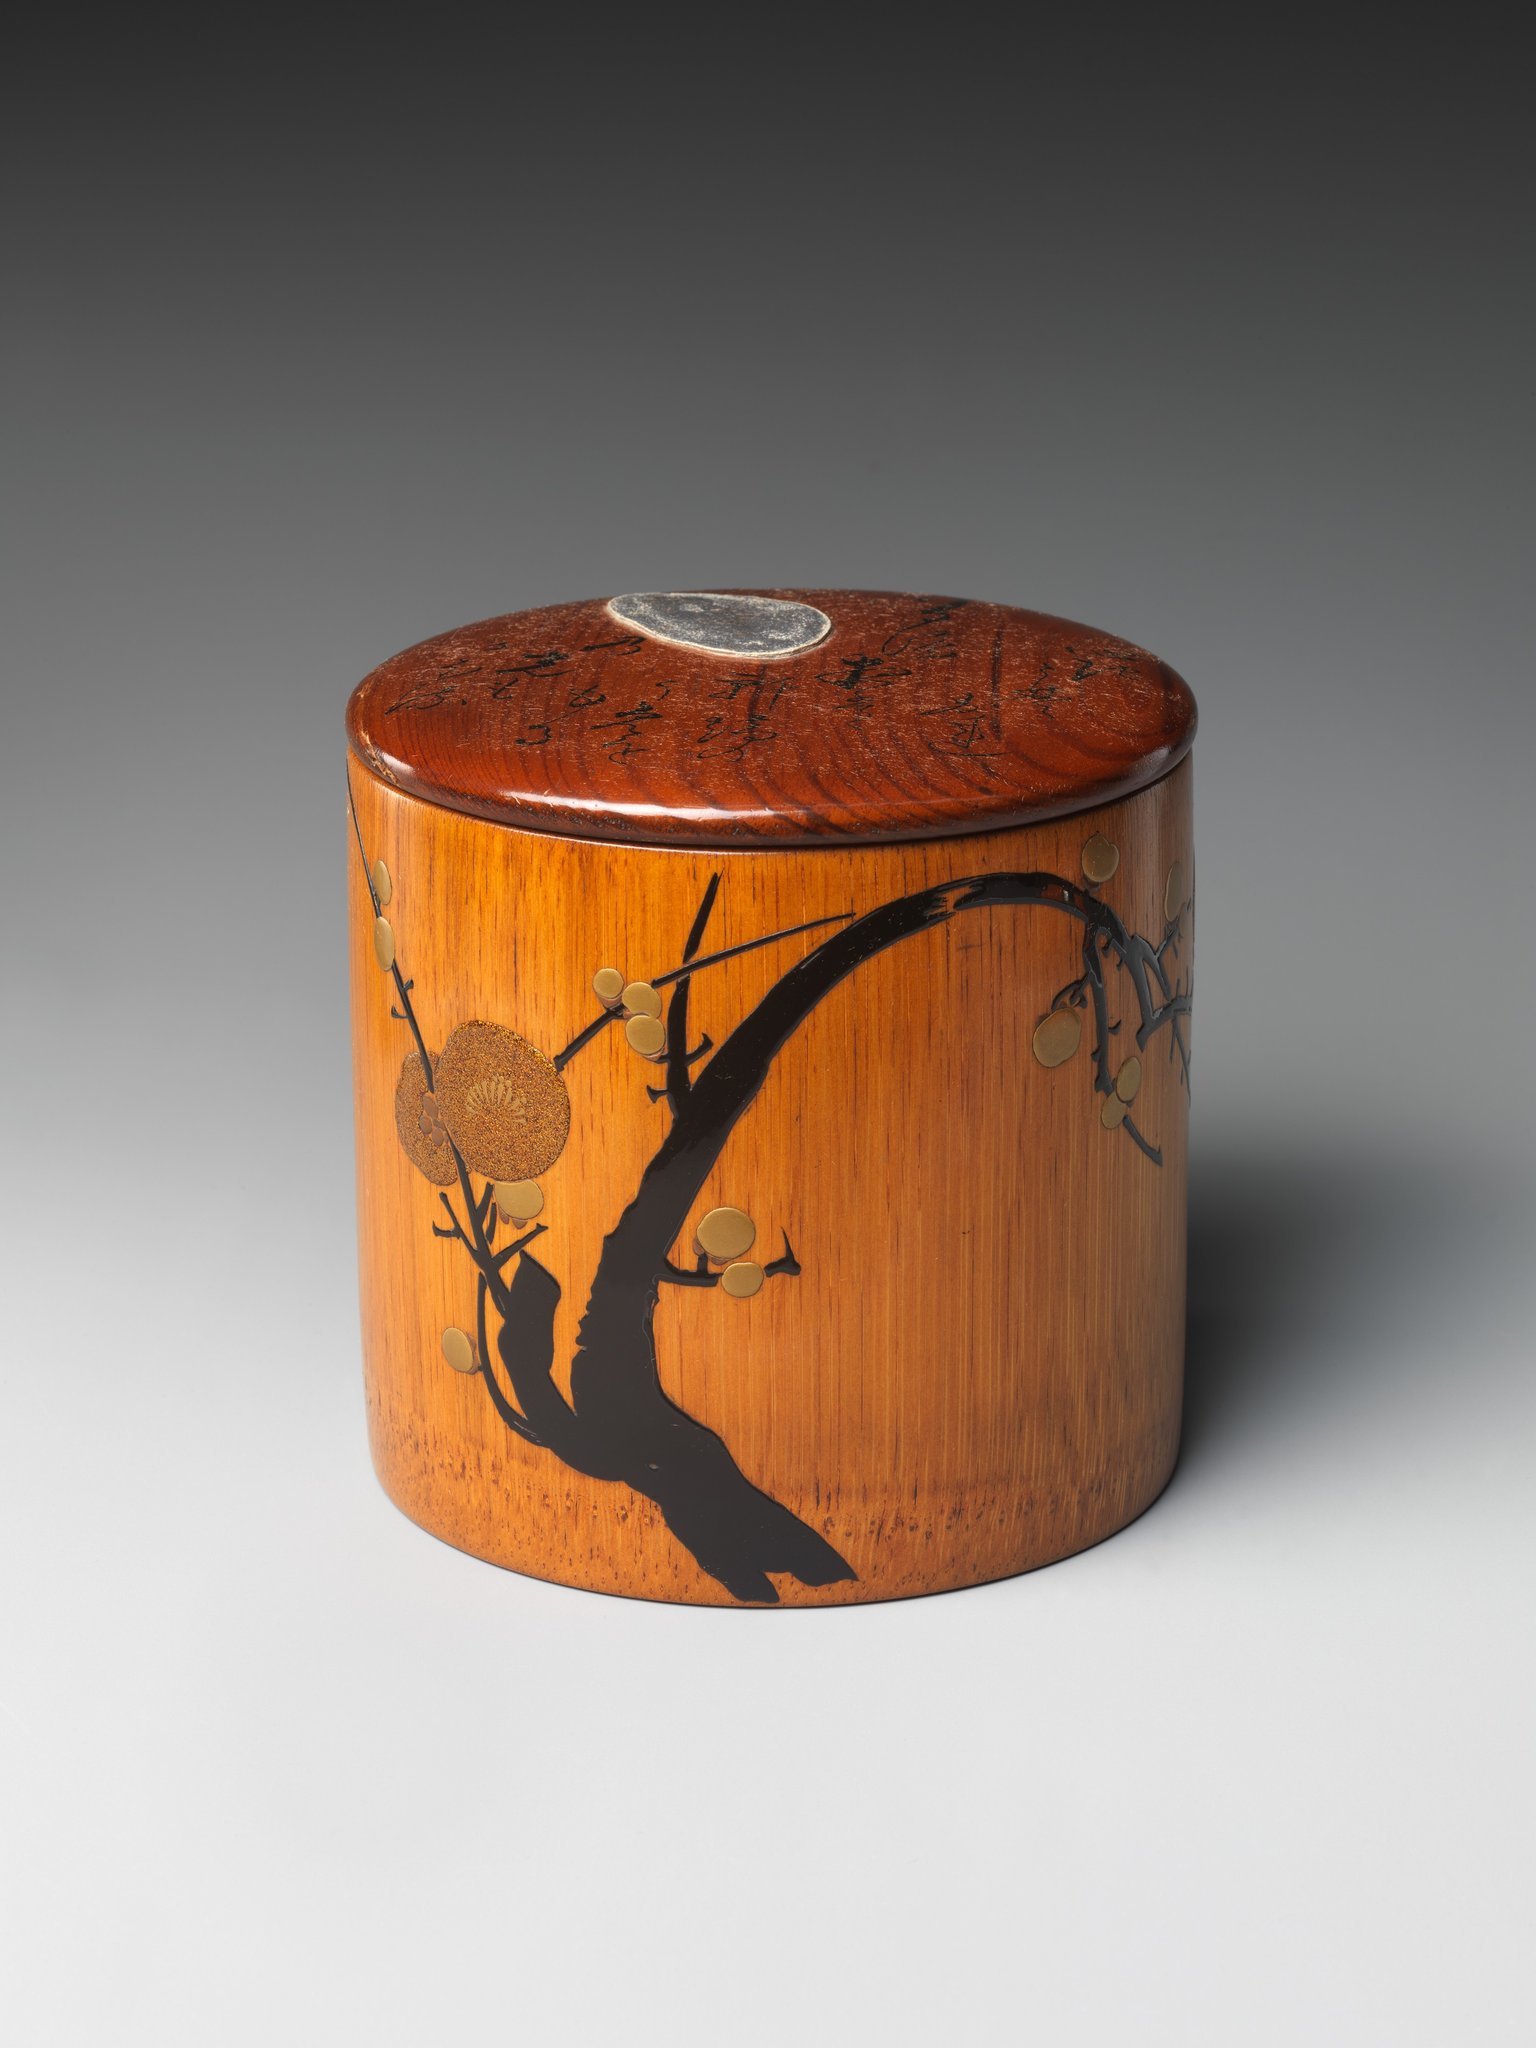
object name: box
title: Box with Design of Plum Tree and Moon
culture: japanese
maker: tansai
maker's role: artist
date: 1801-1900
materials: bamboo, gold, lacquer, pewter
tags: moon,trees